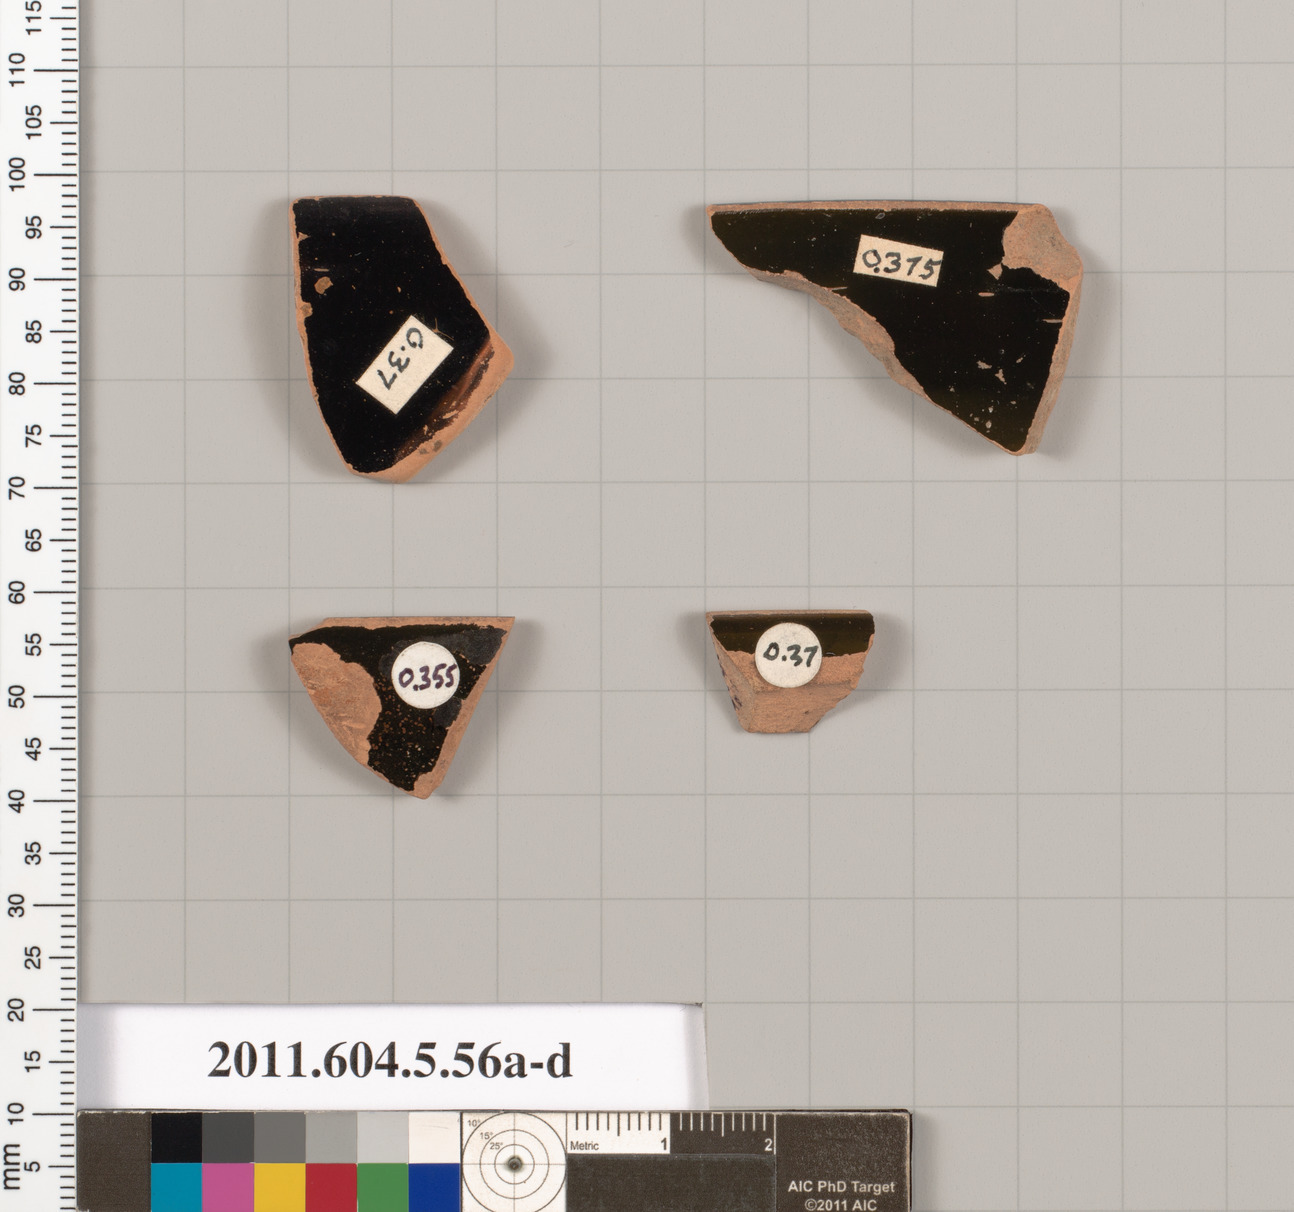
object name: kylix fragment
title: Terracotta rim fragments of kylikes (drinking cups)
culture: greek, attic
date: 500-401 BCE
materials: terracotta